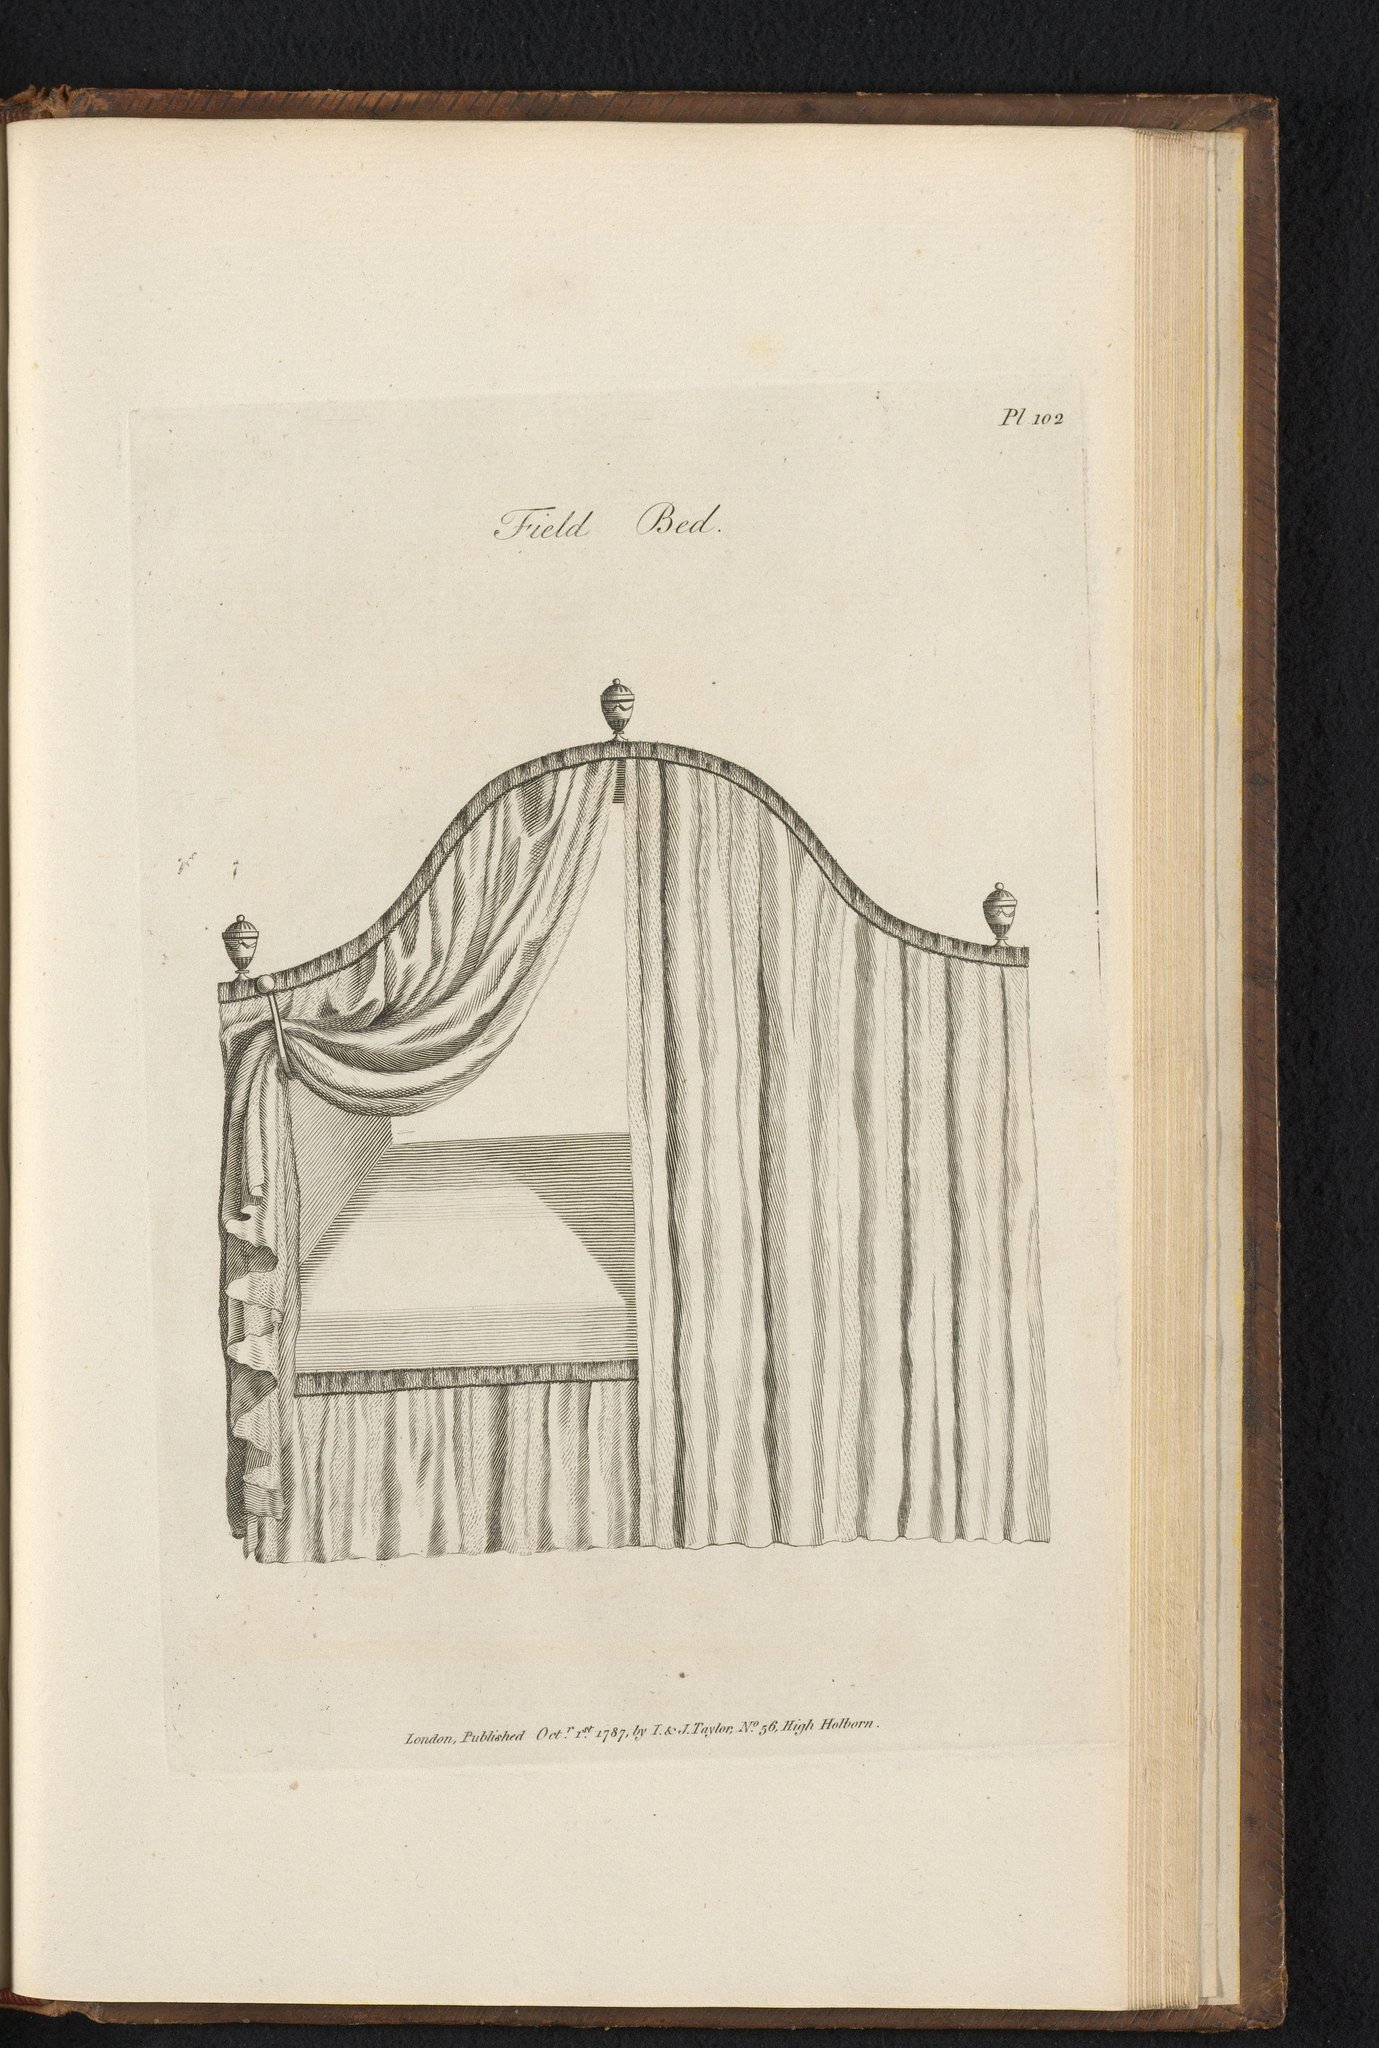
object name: page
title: Meubels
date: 1787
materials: paper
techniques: engraving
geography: holborn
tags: bed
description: Genummerd: Pl. 102. Prent maakt deel uit van een boek.